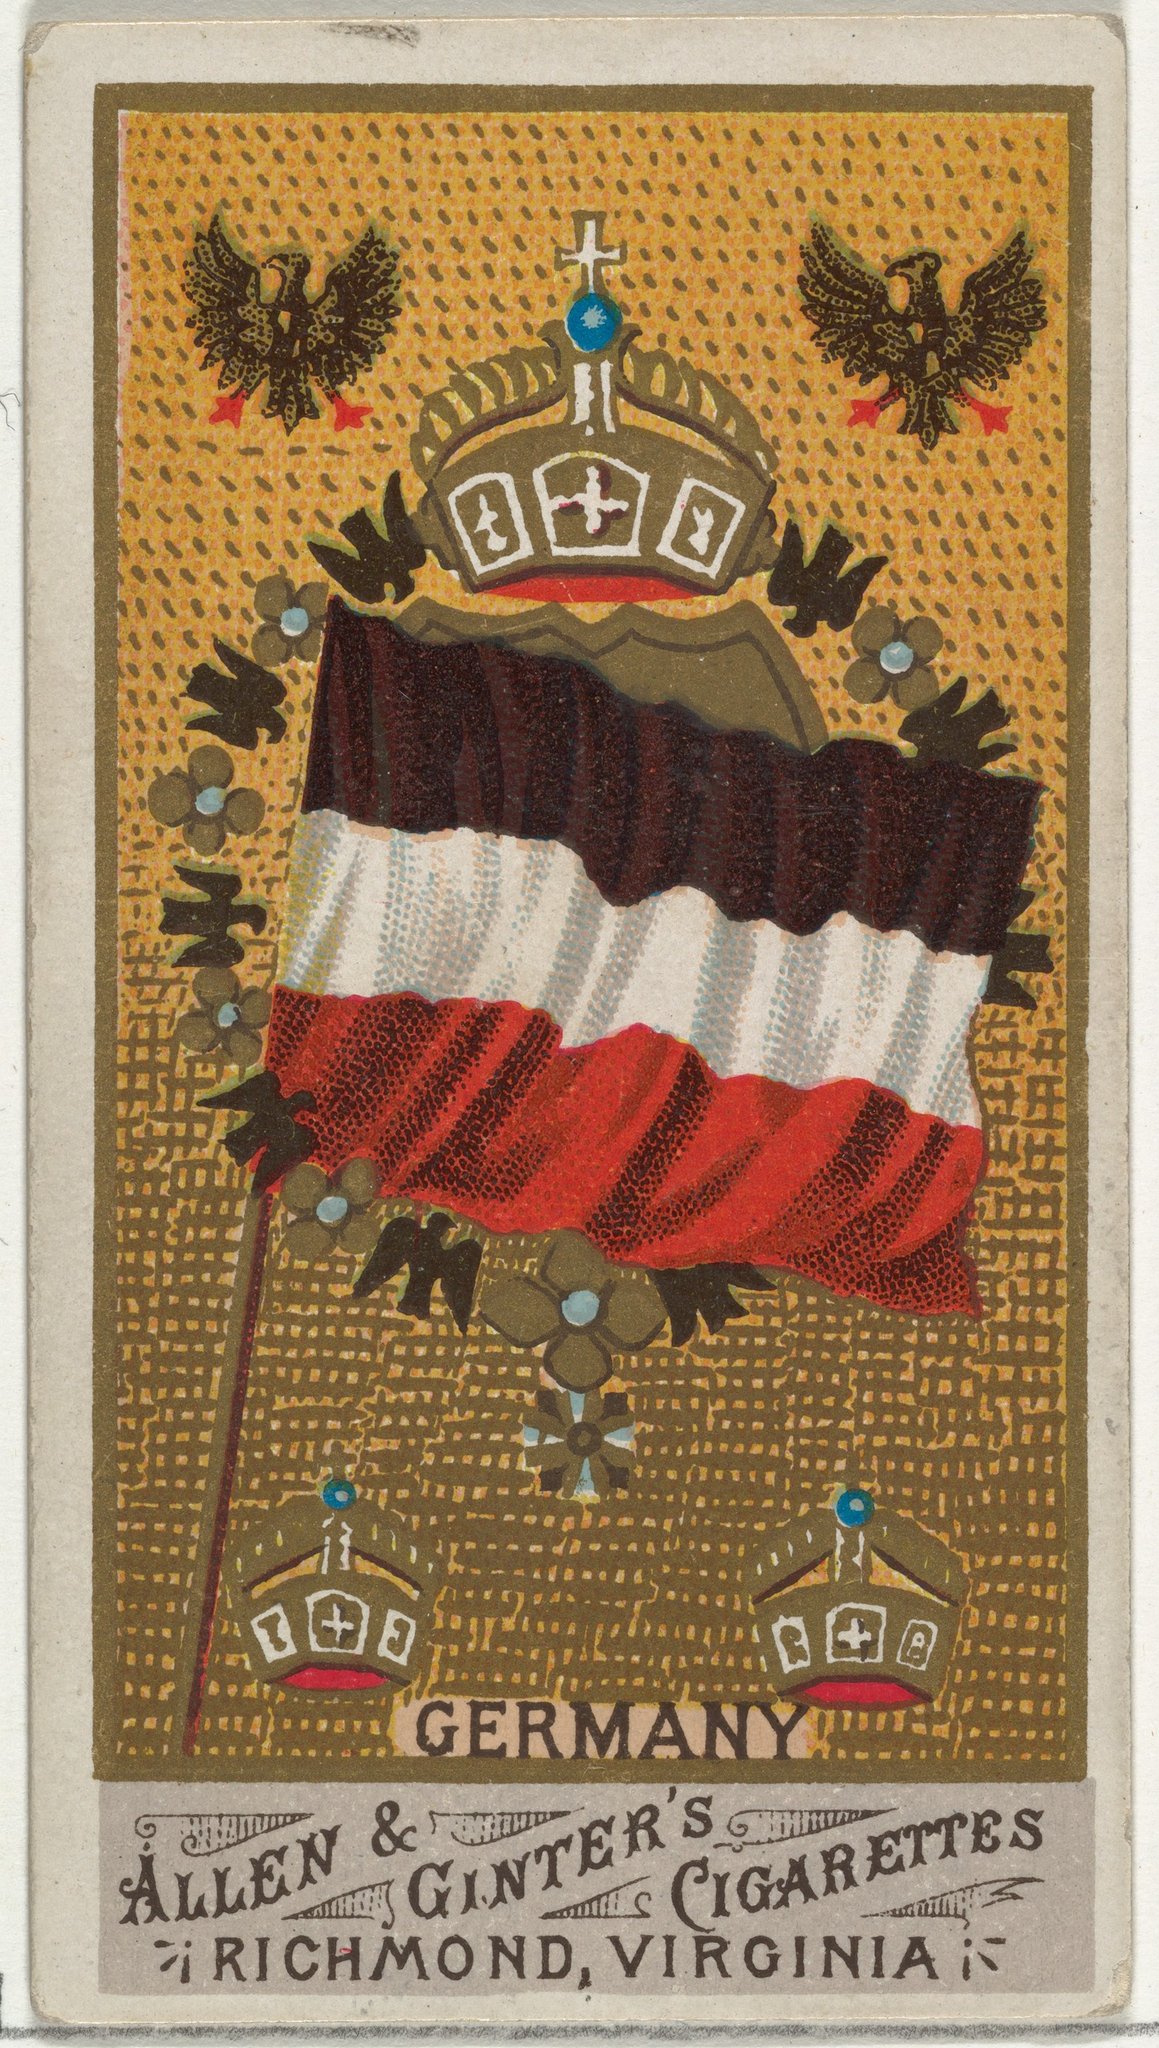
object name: print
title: Germany, from Flags of All Nations, Series 1 (N9) for Allen & Ginter Cigarettes Brands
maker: allen & ginter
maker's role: publisher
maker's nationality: american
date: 1887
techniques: color lithograph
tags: flags